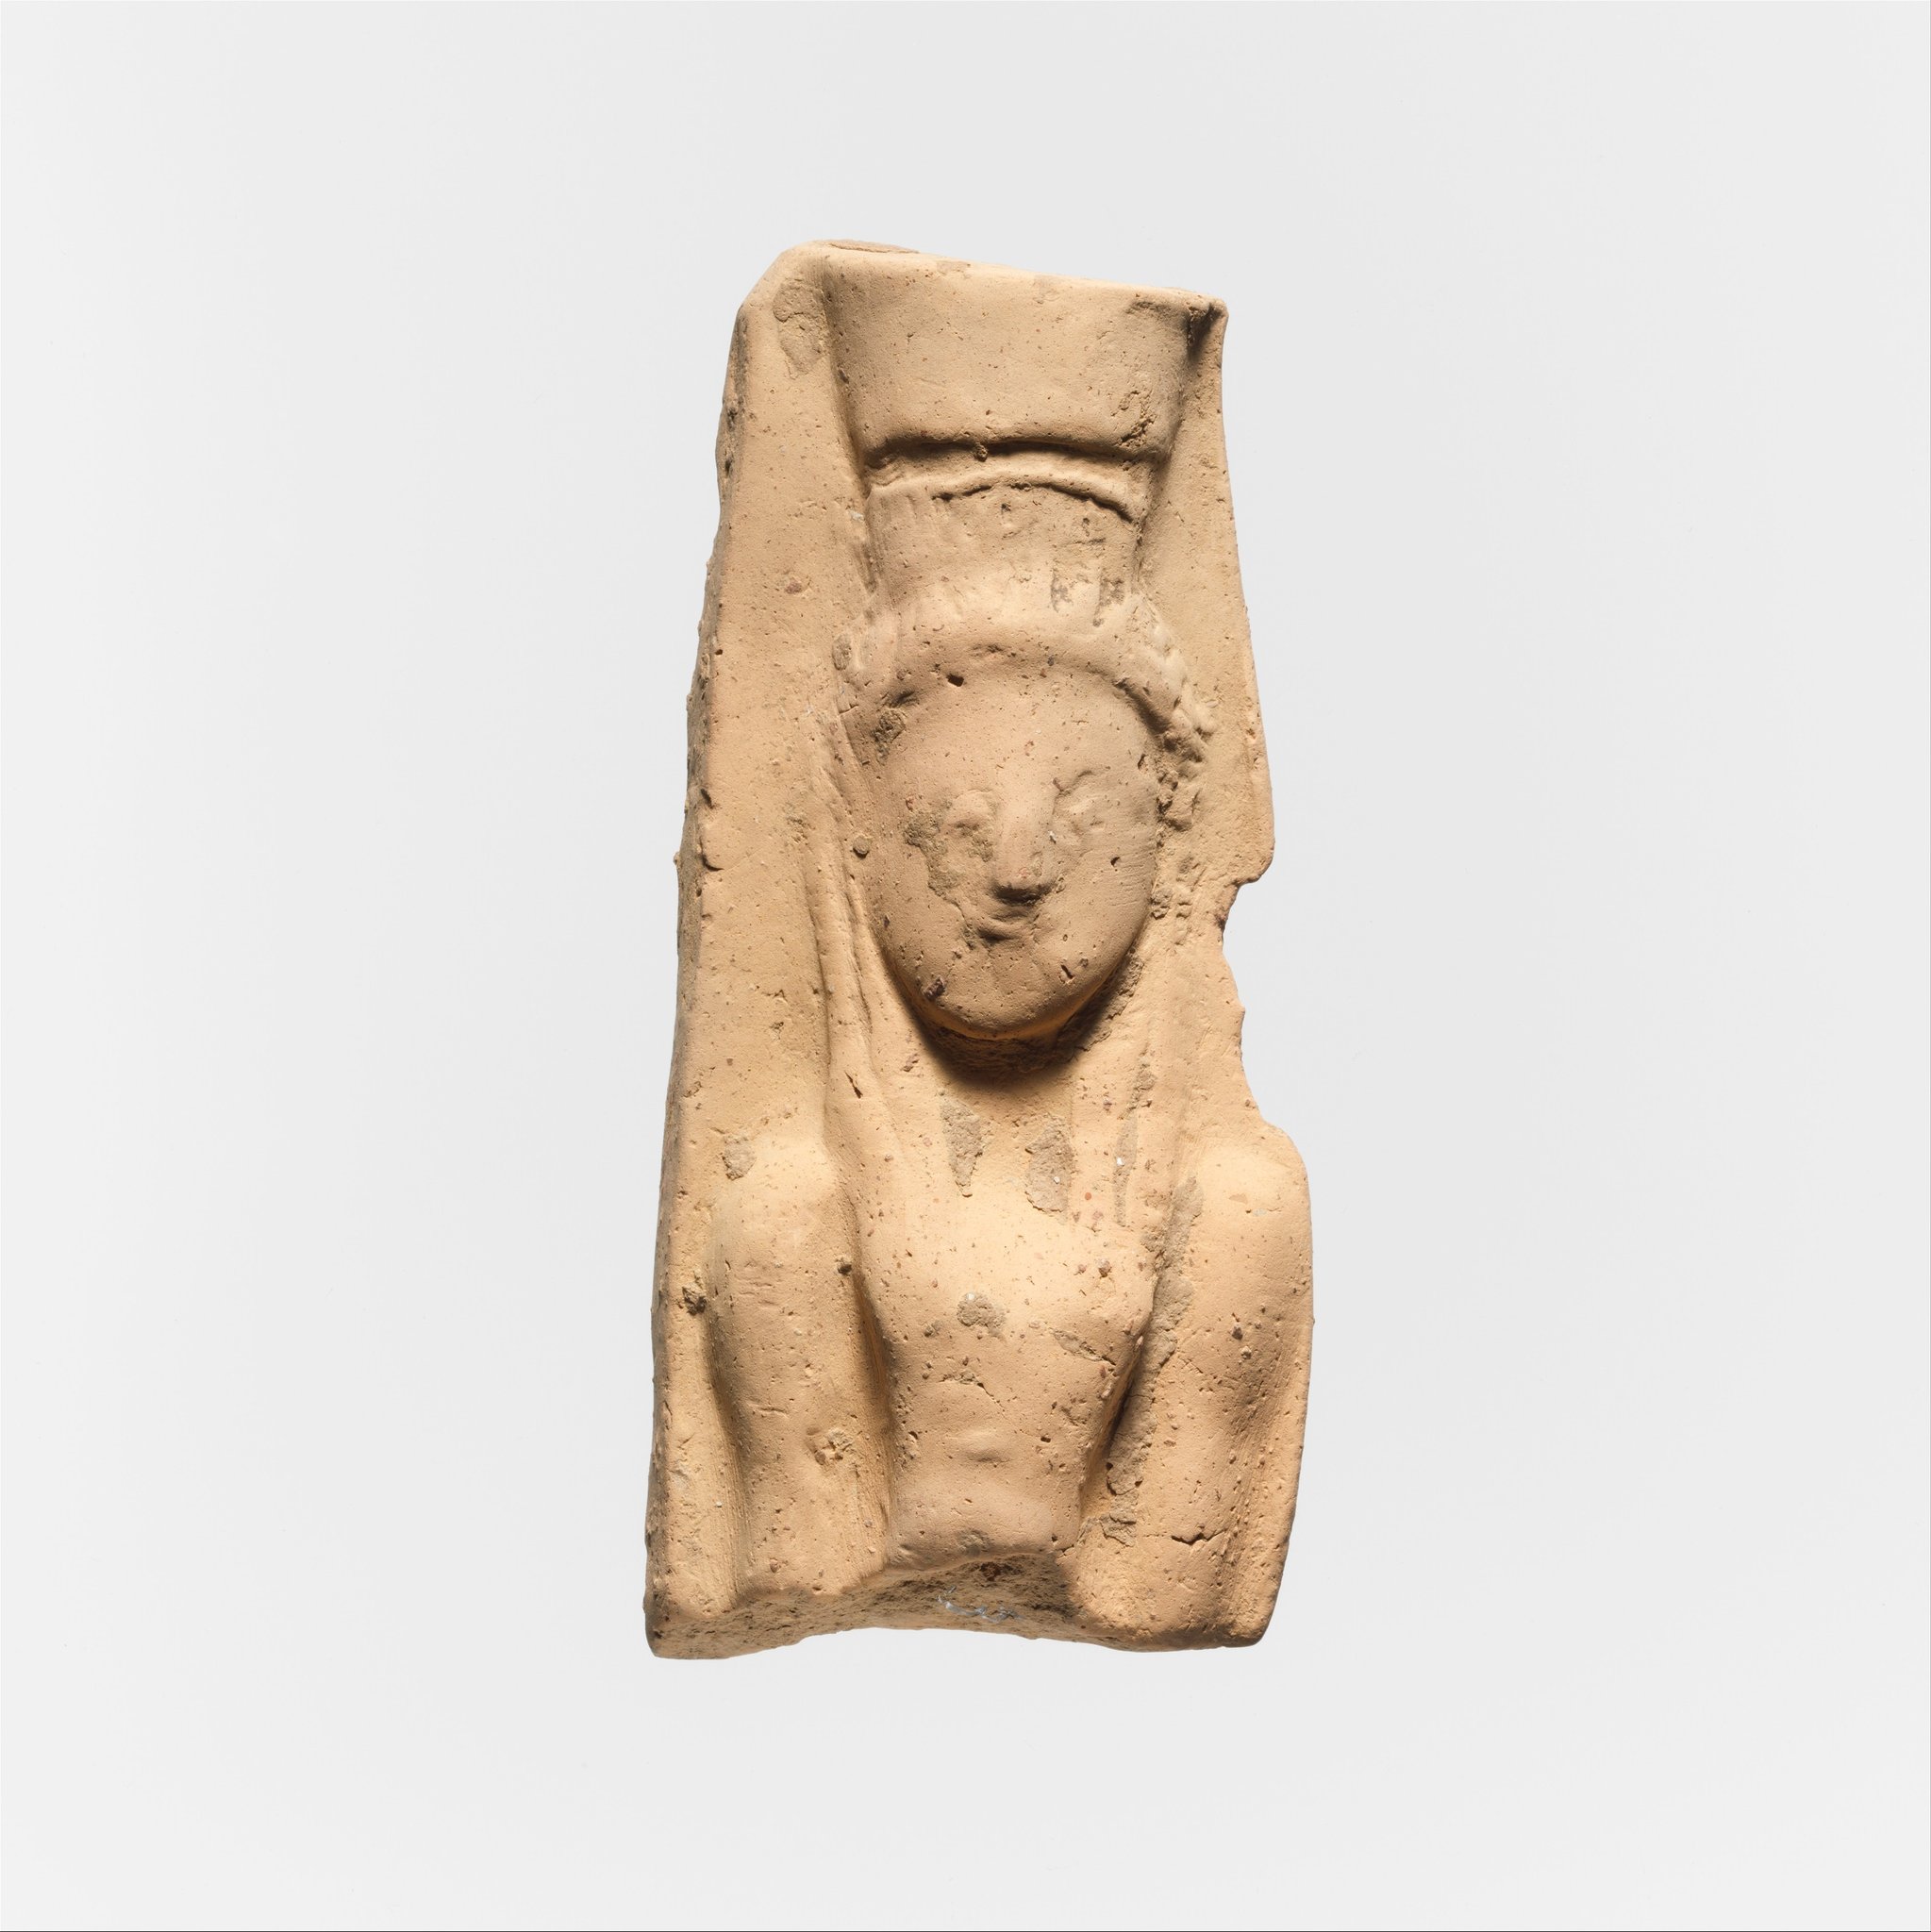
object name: statuette of a female idol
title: Fragment of a terracotta plaque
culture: greek, cretan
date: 700-601 BCE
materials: terracotta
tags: women